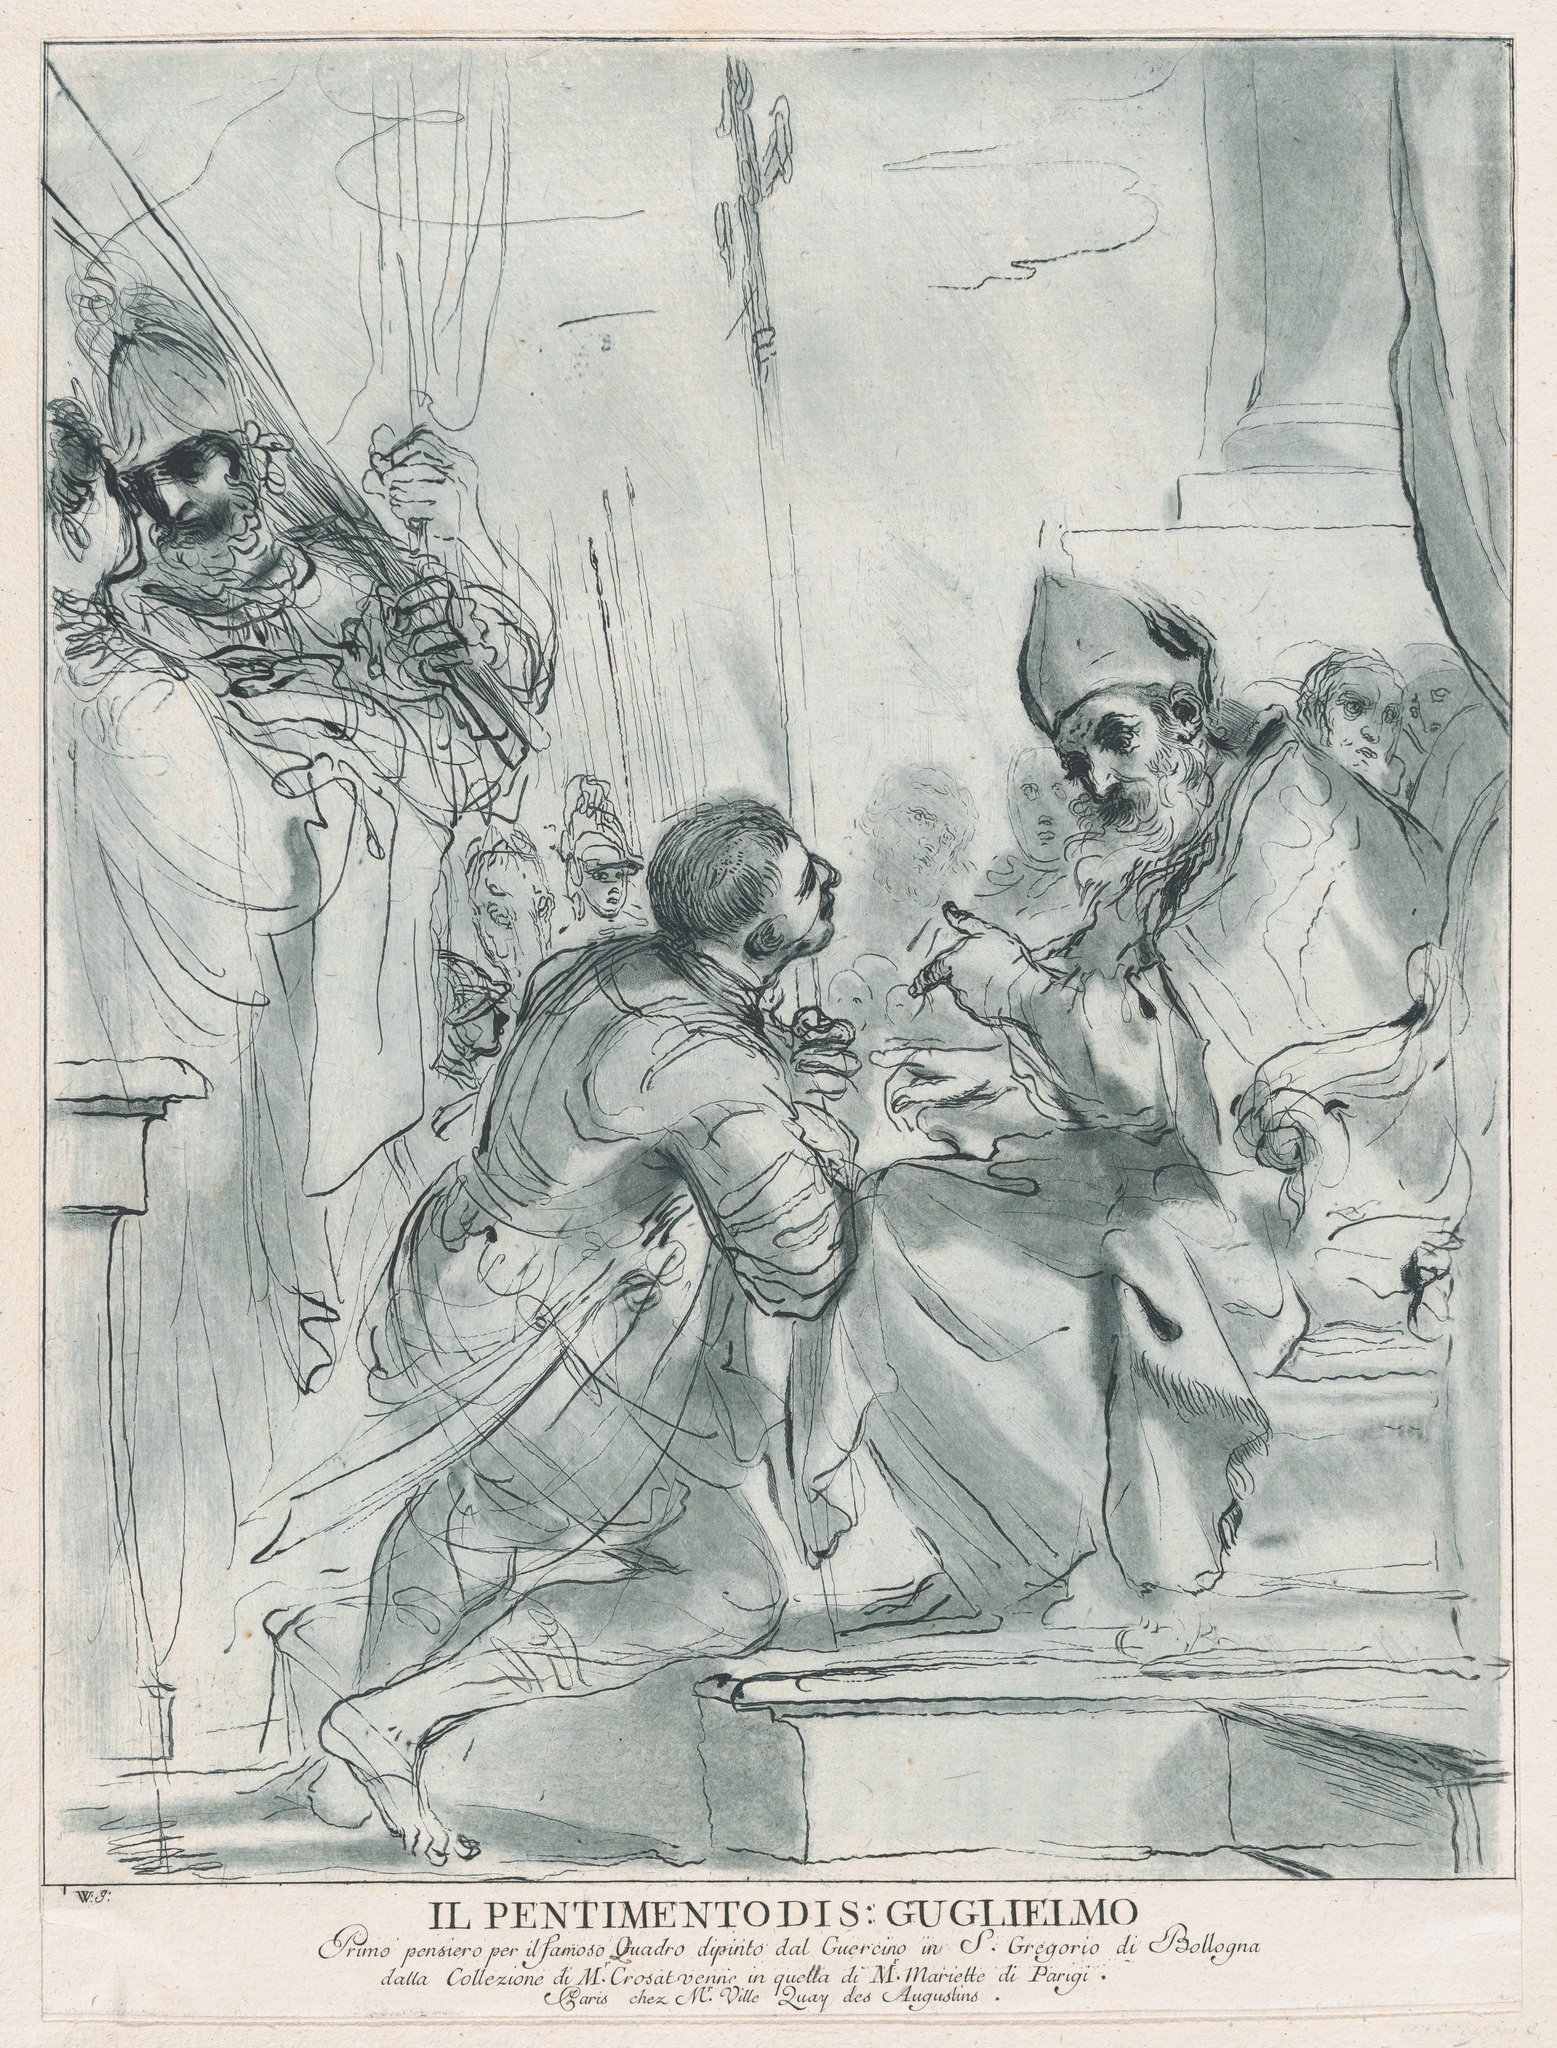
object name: print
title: Repentance of St. William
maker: vincenzio vangelisti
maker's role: etcher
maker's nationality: italian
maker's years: 1728-1798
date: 1764-1798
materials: ink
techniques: engraving, etching, printing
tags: men,saints